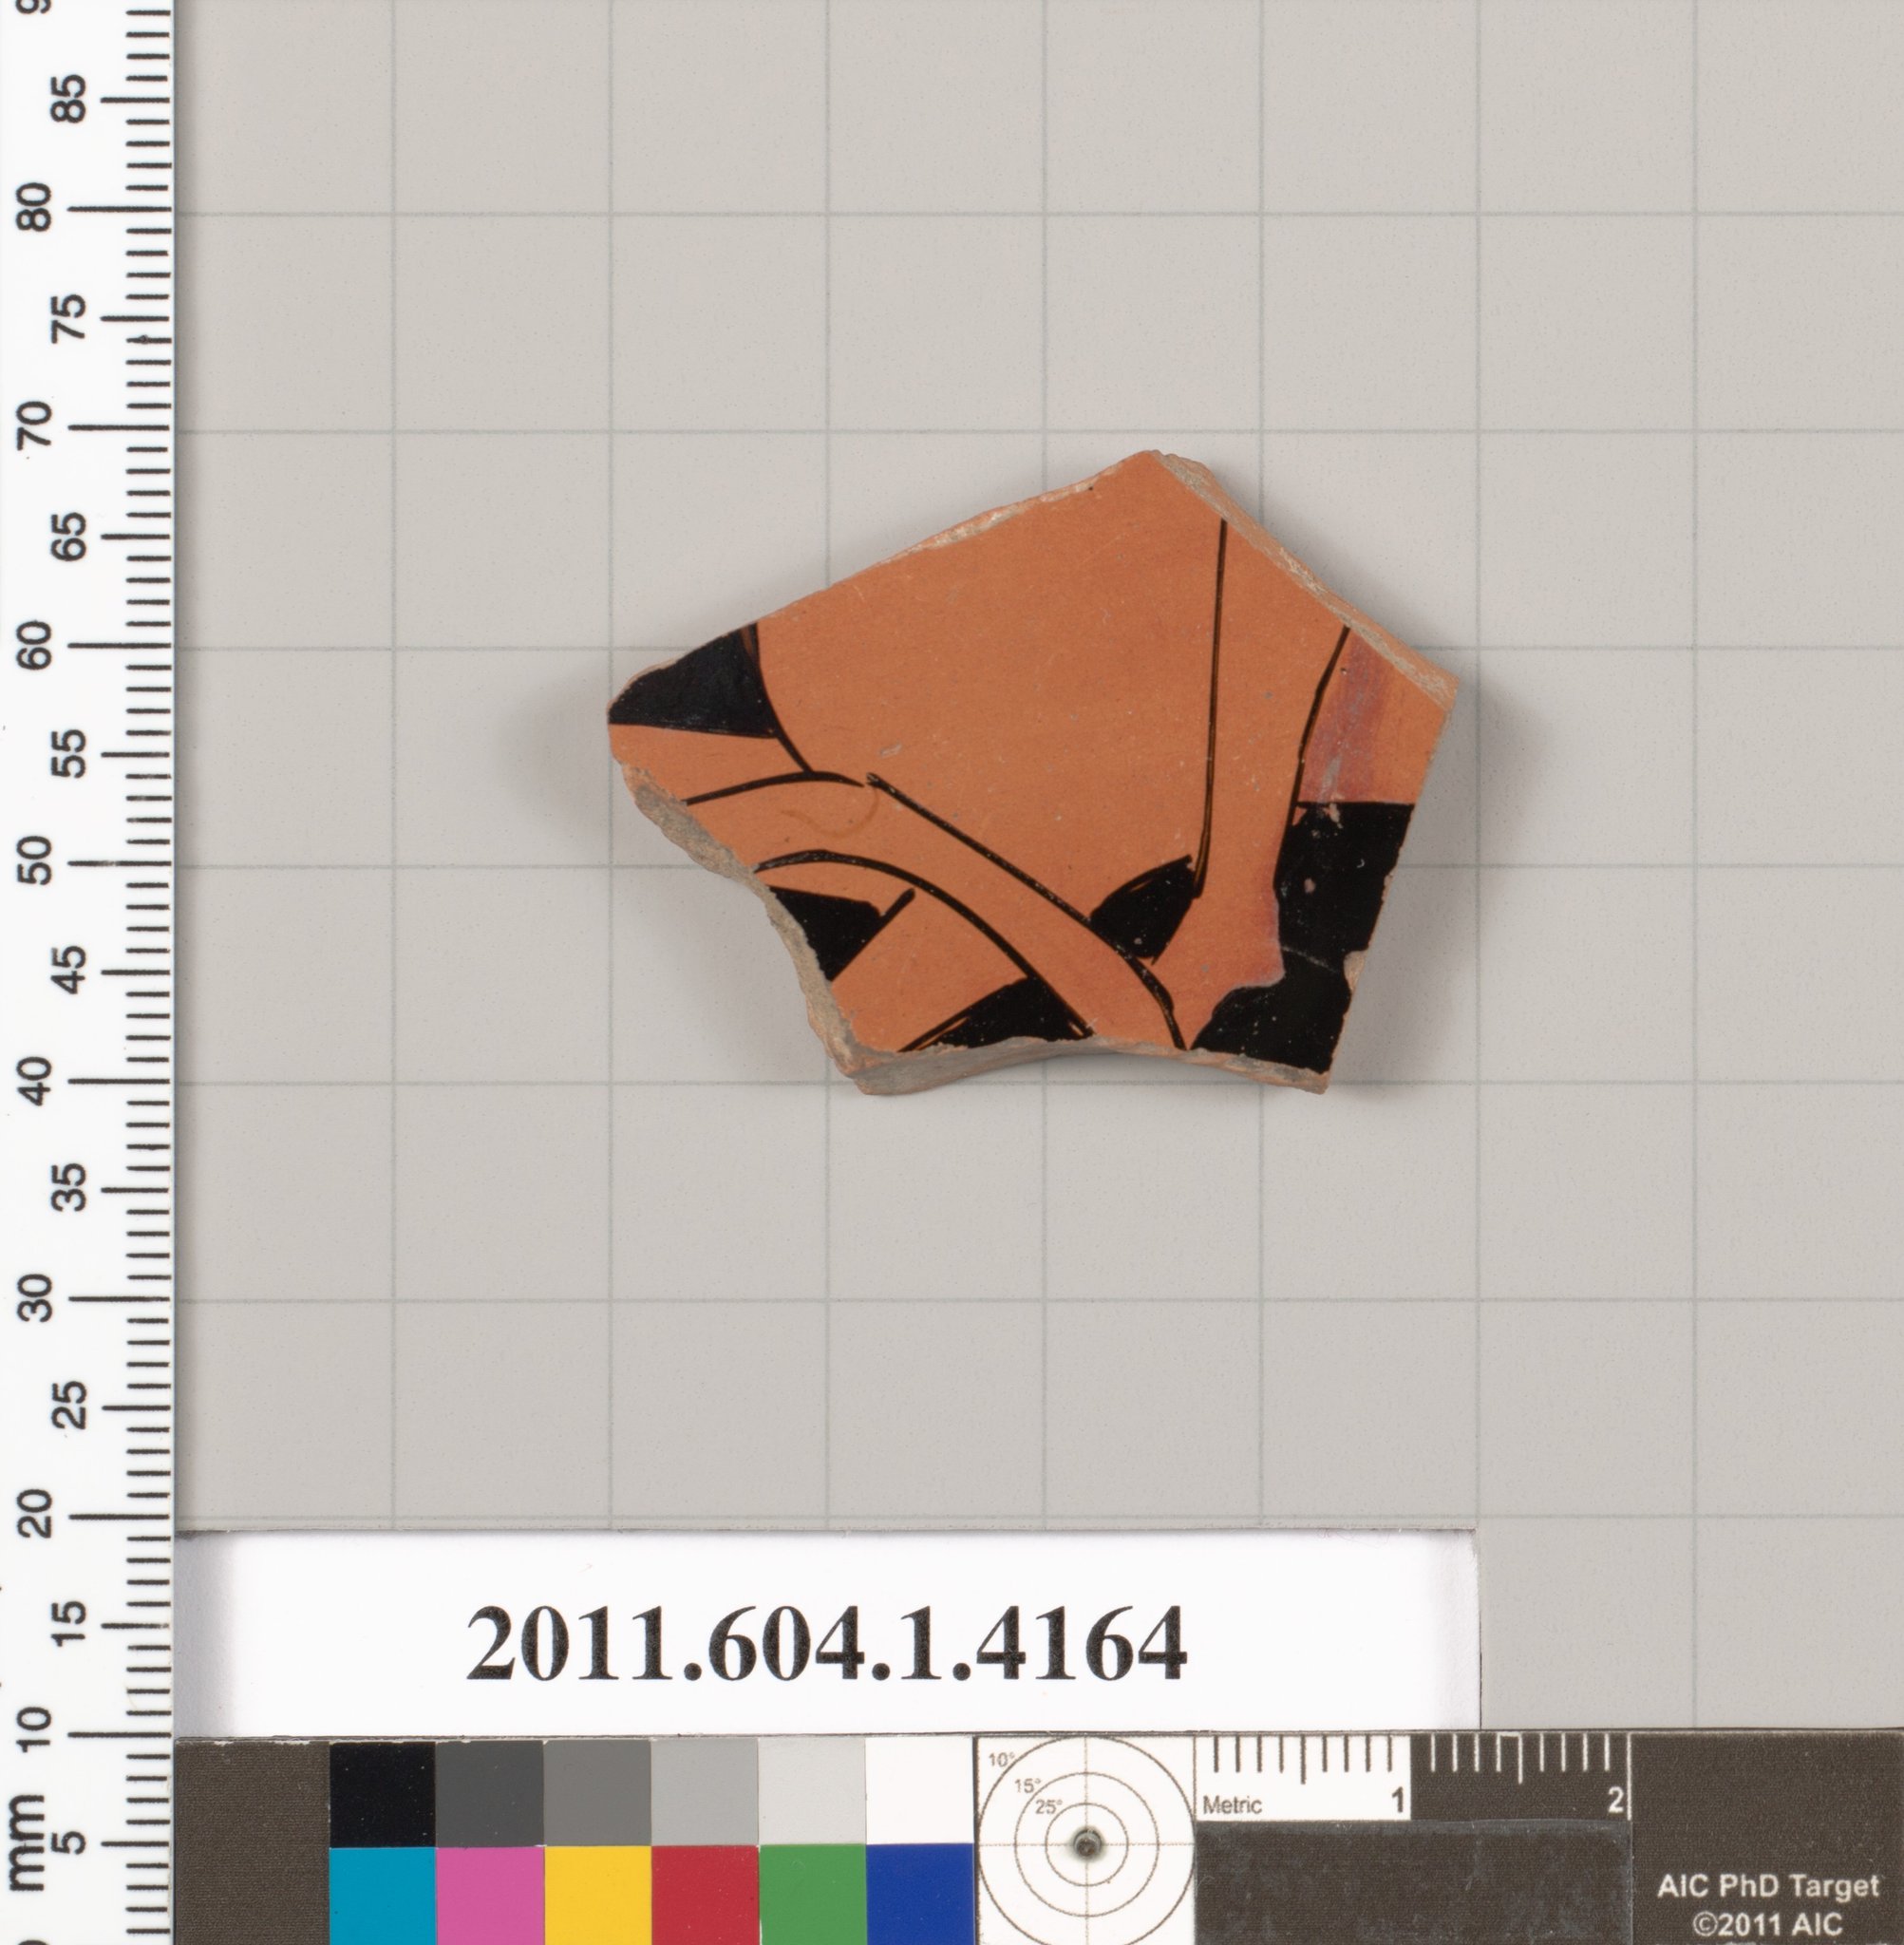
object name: kylix fragment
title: Terracotta fragment of a kylix (drinking cup)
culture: greek, attic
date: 500-480 BCE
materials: terracotta